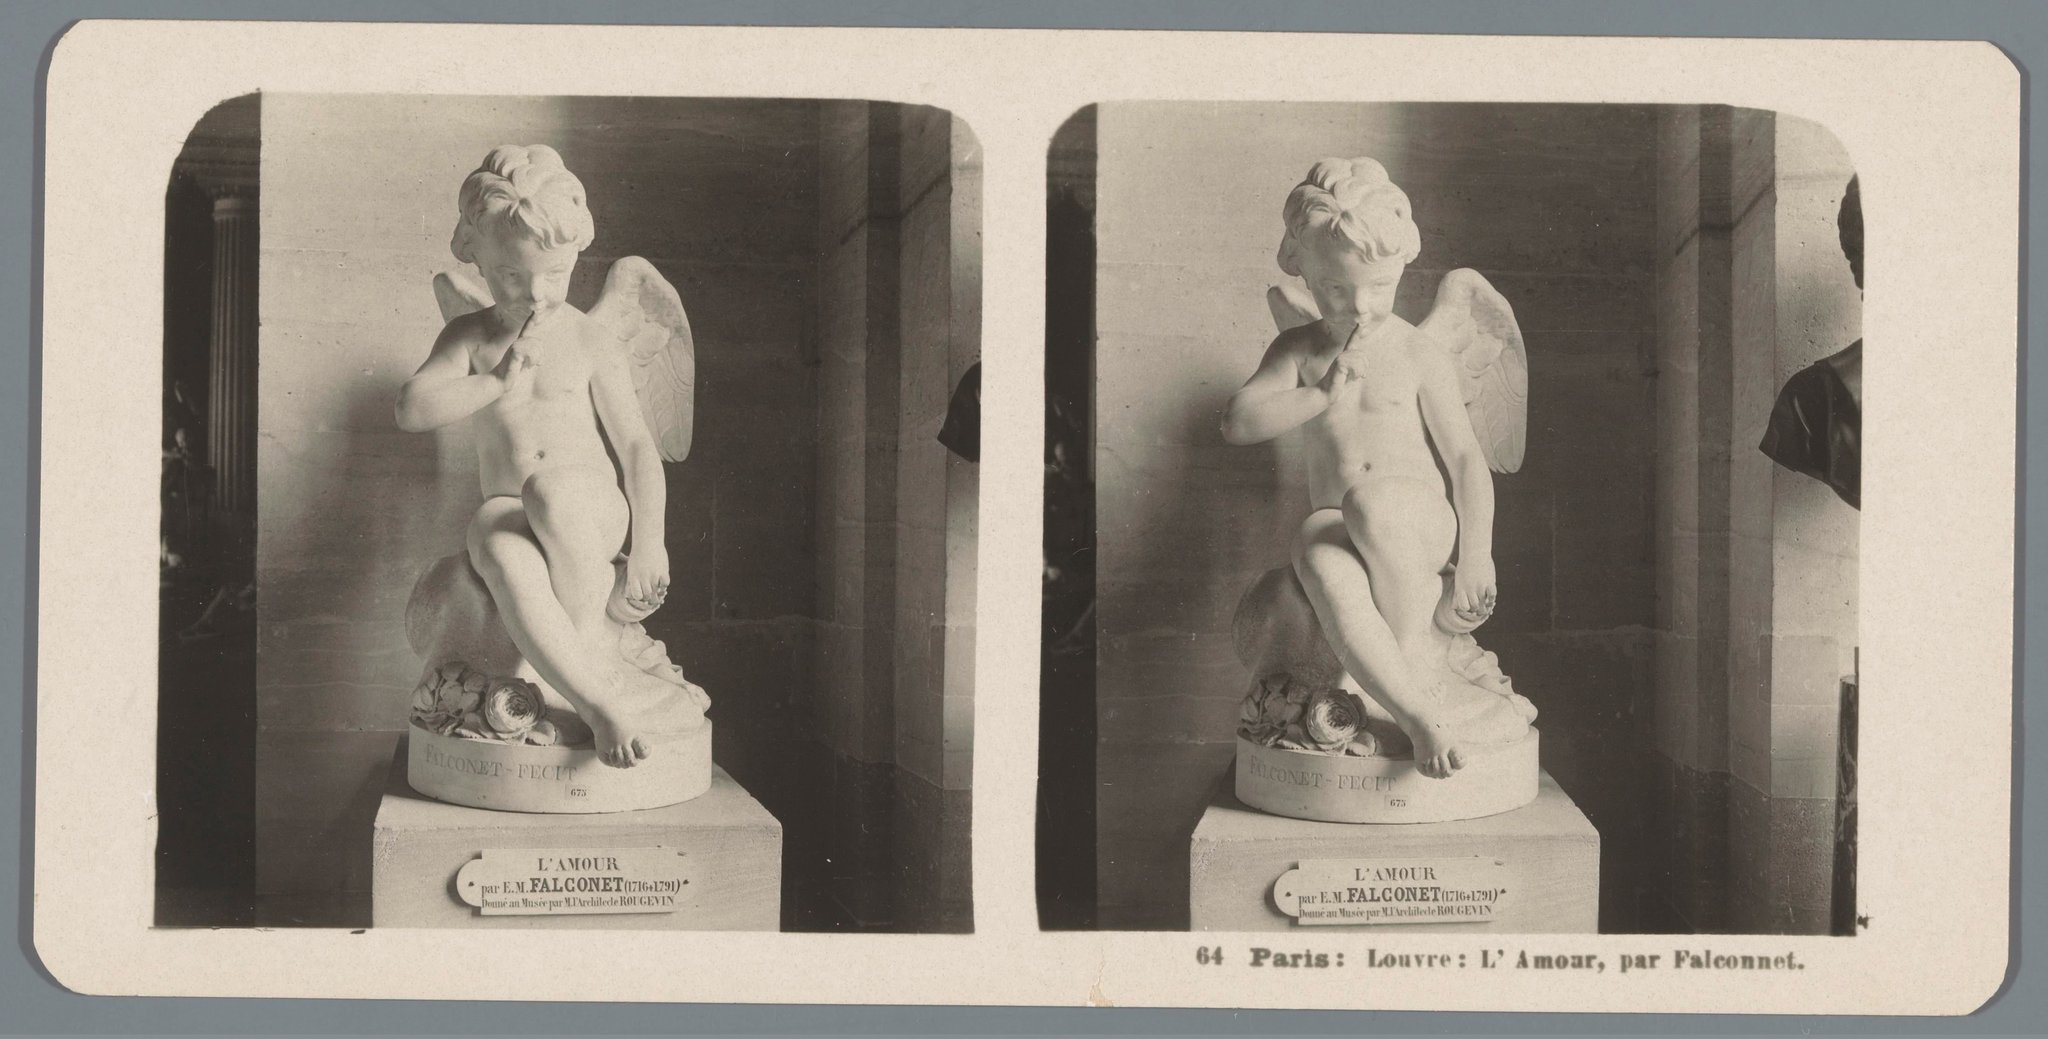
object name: stereograph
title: Paris: Louvre: L'Amour, par Falconnet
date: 1904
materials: cardboard, photographic support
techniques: gelatin silver print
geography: louvre museum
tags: sitting figure - aa - female human figure, (story of) cupid, amor (eros), sculpture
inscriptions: number: ‘64’, inscription: ‘Neue Photographische Gesellschaft A.-G. Steglitz-Berlin 1904.’